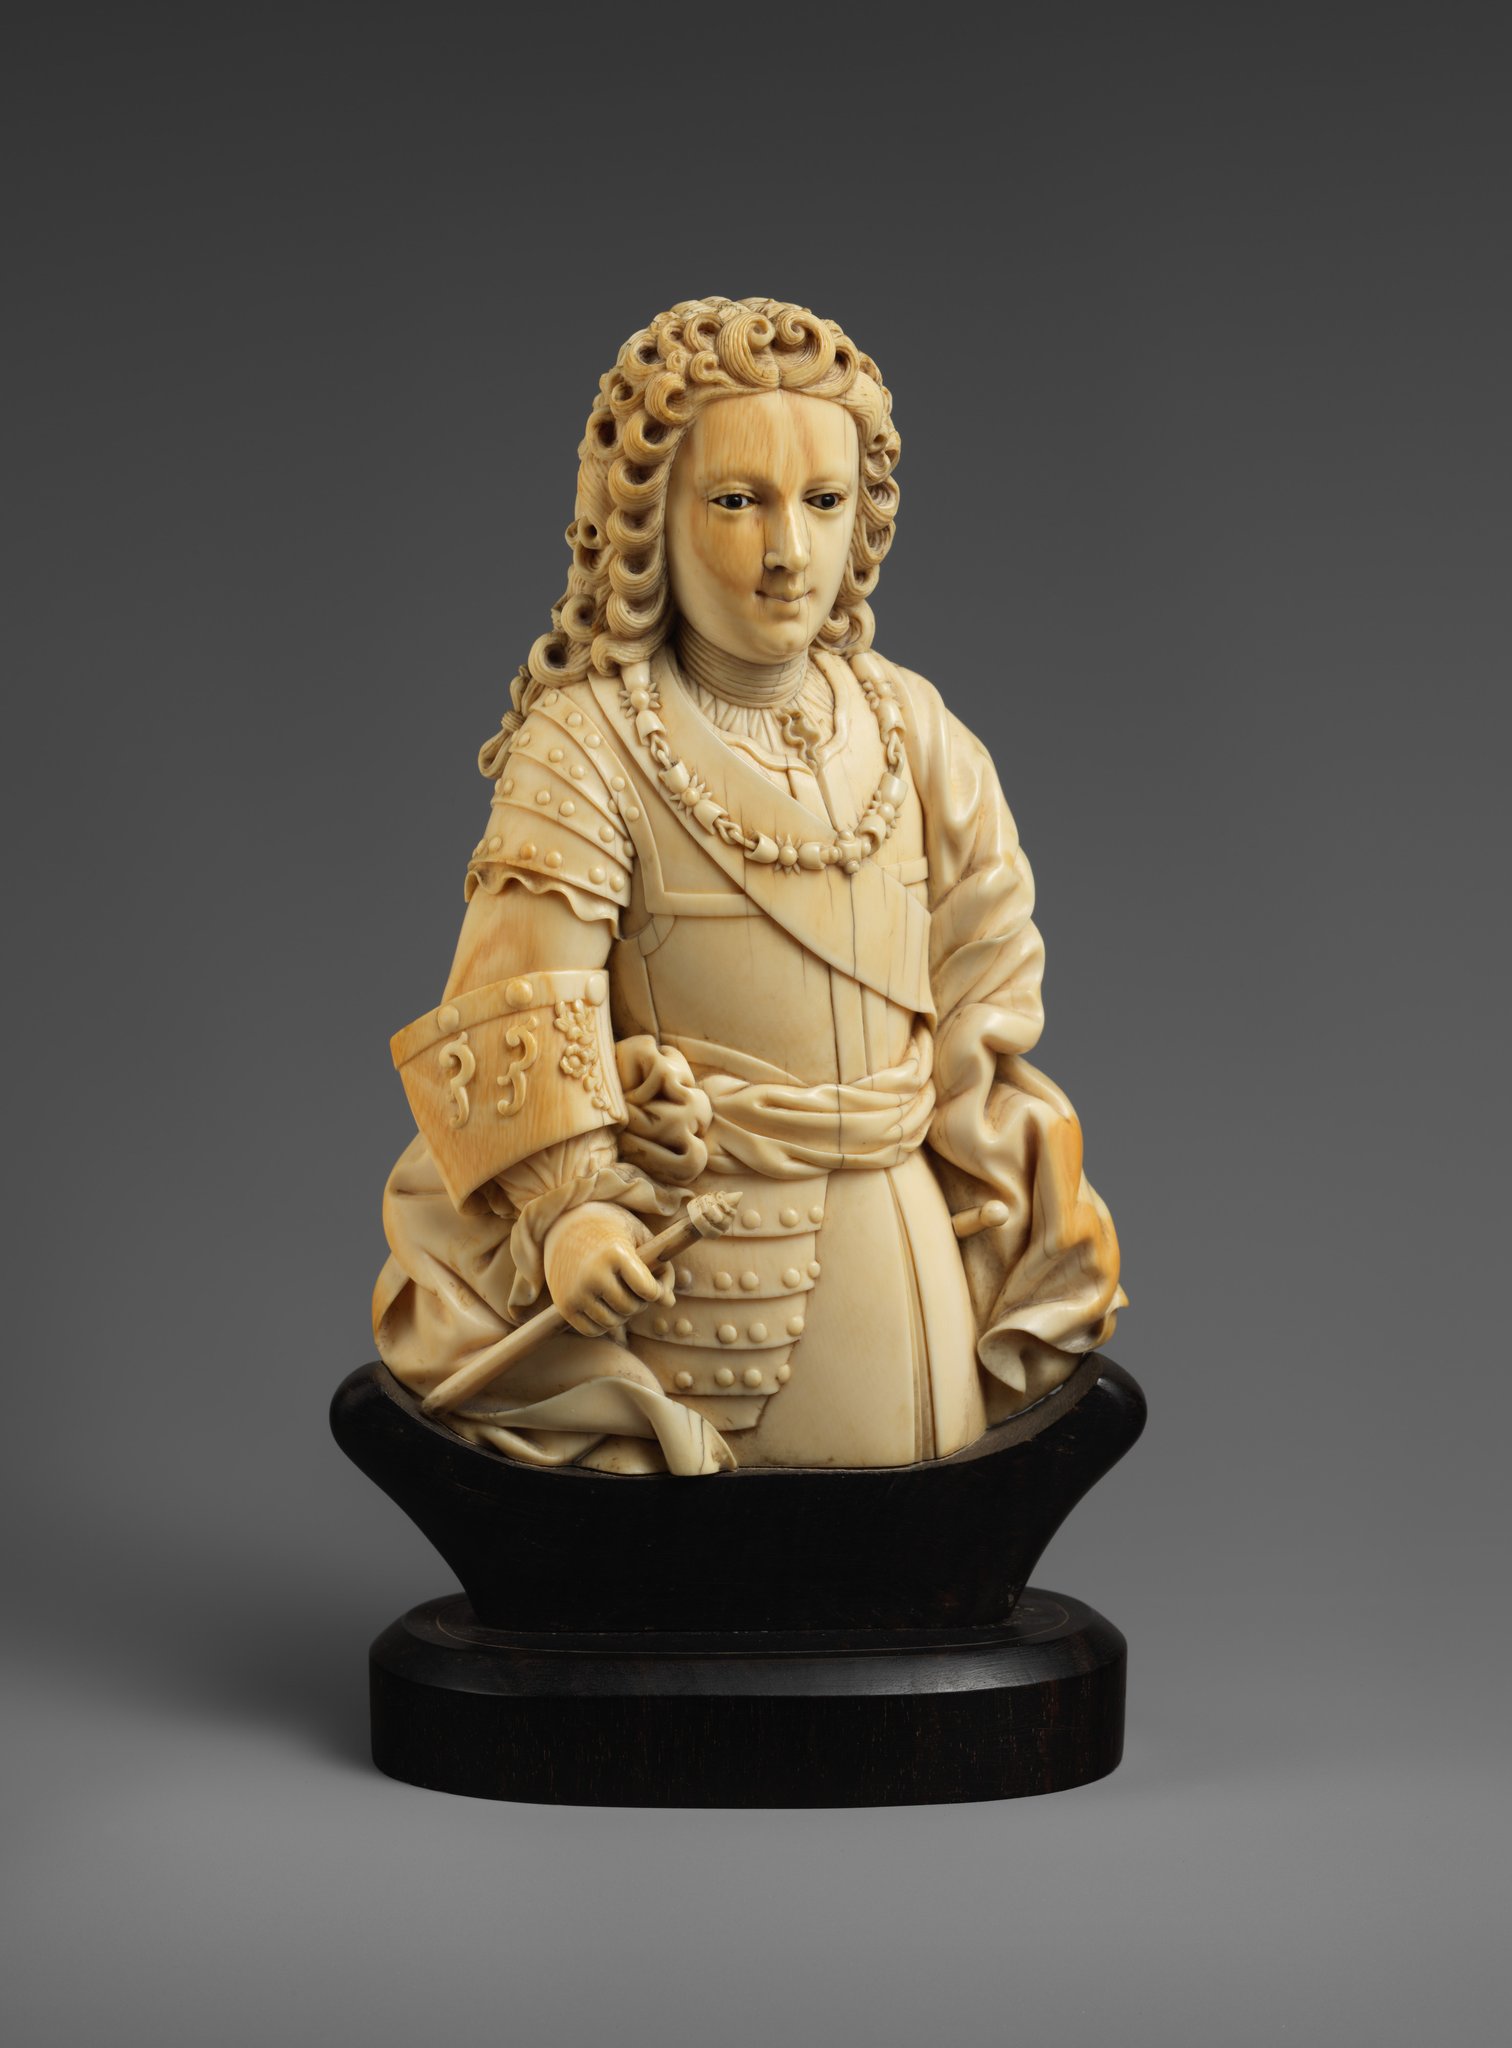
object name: bust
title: Fernando VI of Spain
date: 1701-1800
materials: wood, ivory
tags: men